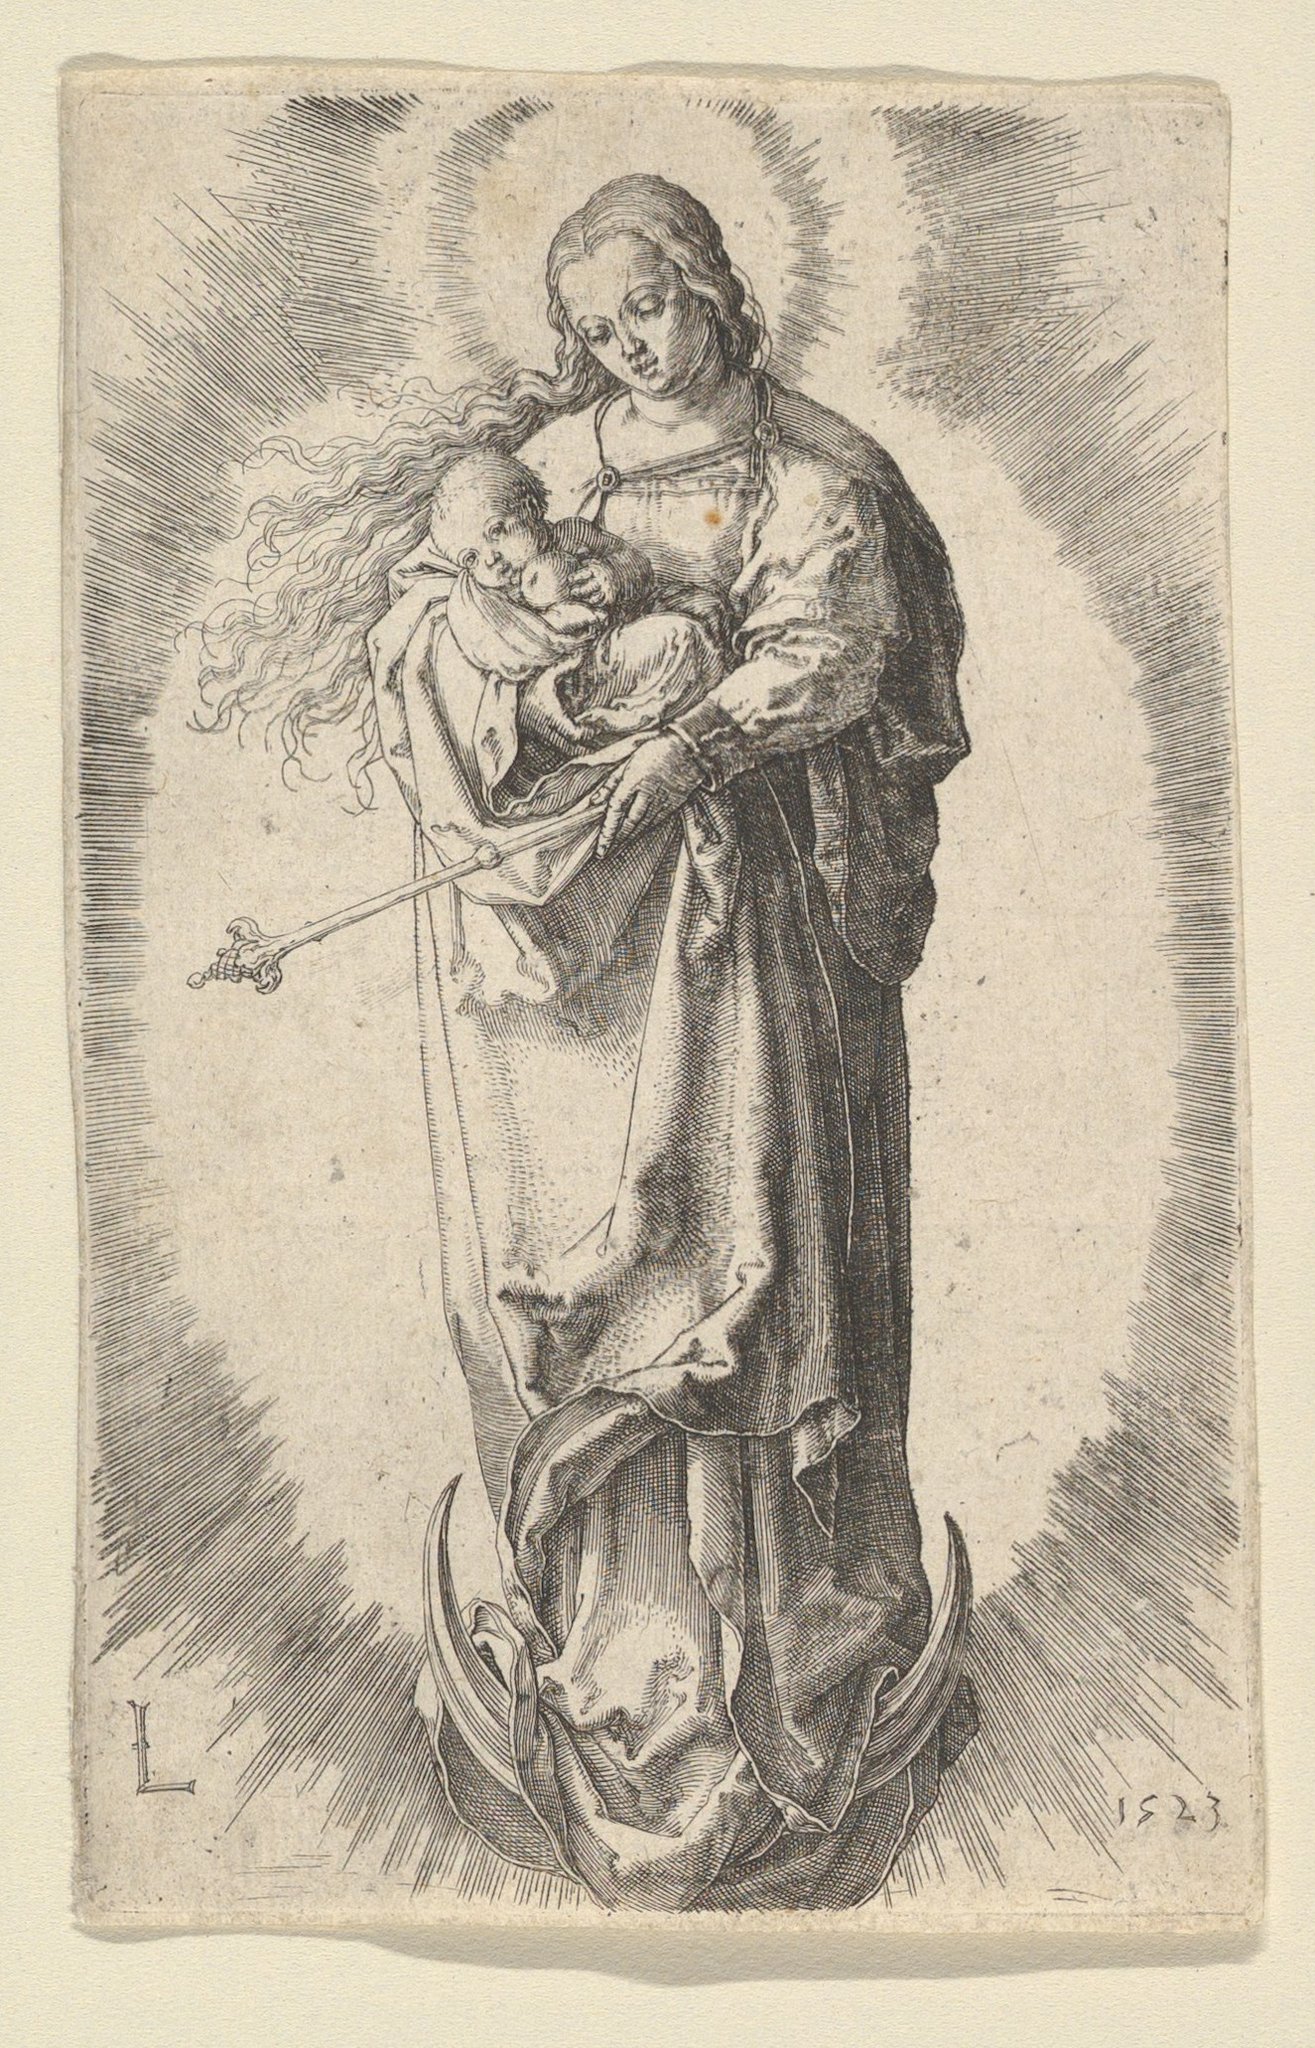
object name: print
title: The Virgin with Child on the Crescent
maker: lucas van leyden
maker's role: artist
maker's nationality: netherlandish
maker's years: 1494-1533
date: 1523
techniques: engraving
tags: infants,virgin mary